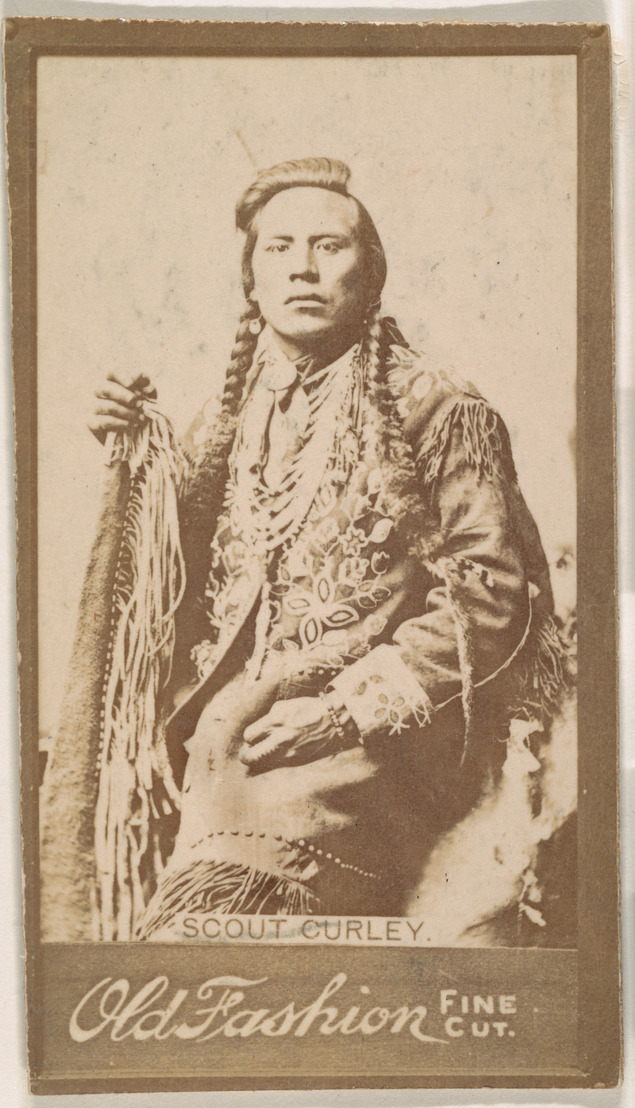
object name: photograph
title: Scout Curley, from the Indian Chiefs series (N681) promoting Old Fashion Fine Cut Tobacco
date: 1888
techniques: albumen silver print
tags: men,portraits